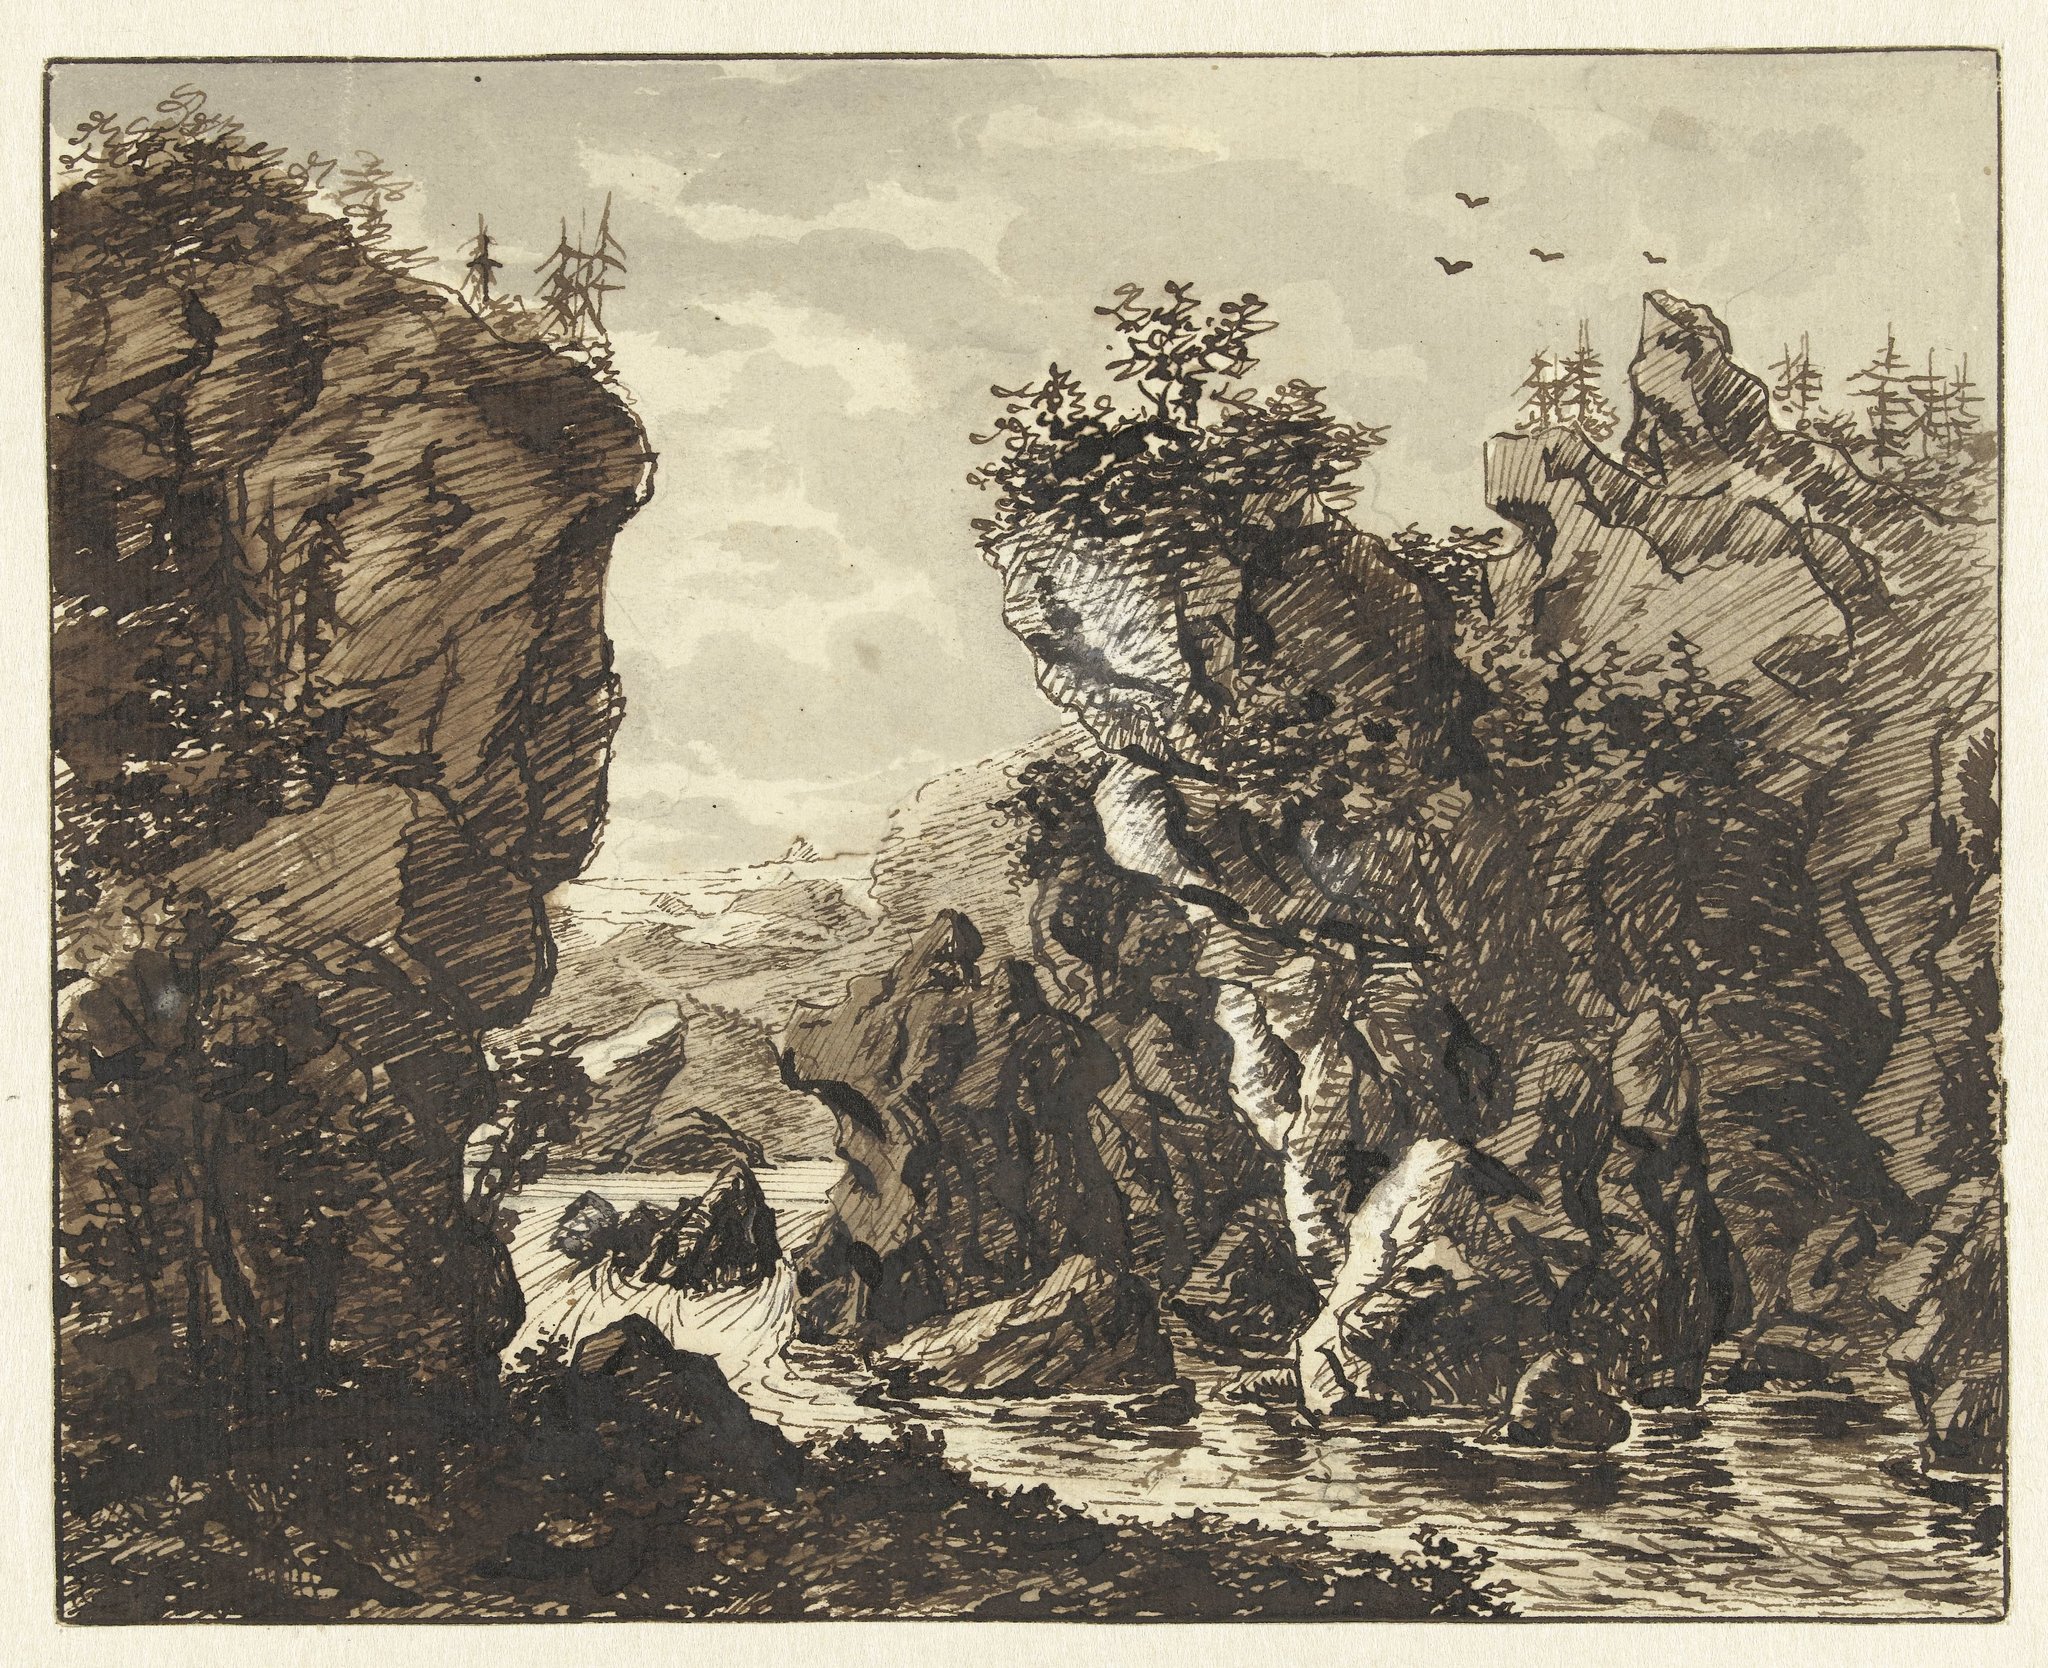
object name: drawing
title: Landschap met rivier tussen rotsen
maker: ernst willem jan bagelaar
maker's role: draughtsman, print maker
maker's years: 1775-1837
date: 1785-1837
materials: paint, ink, paper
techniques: brush, pen